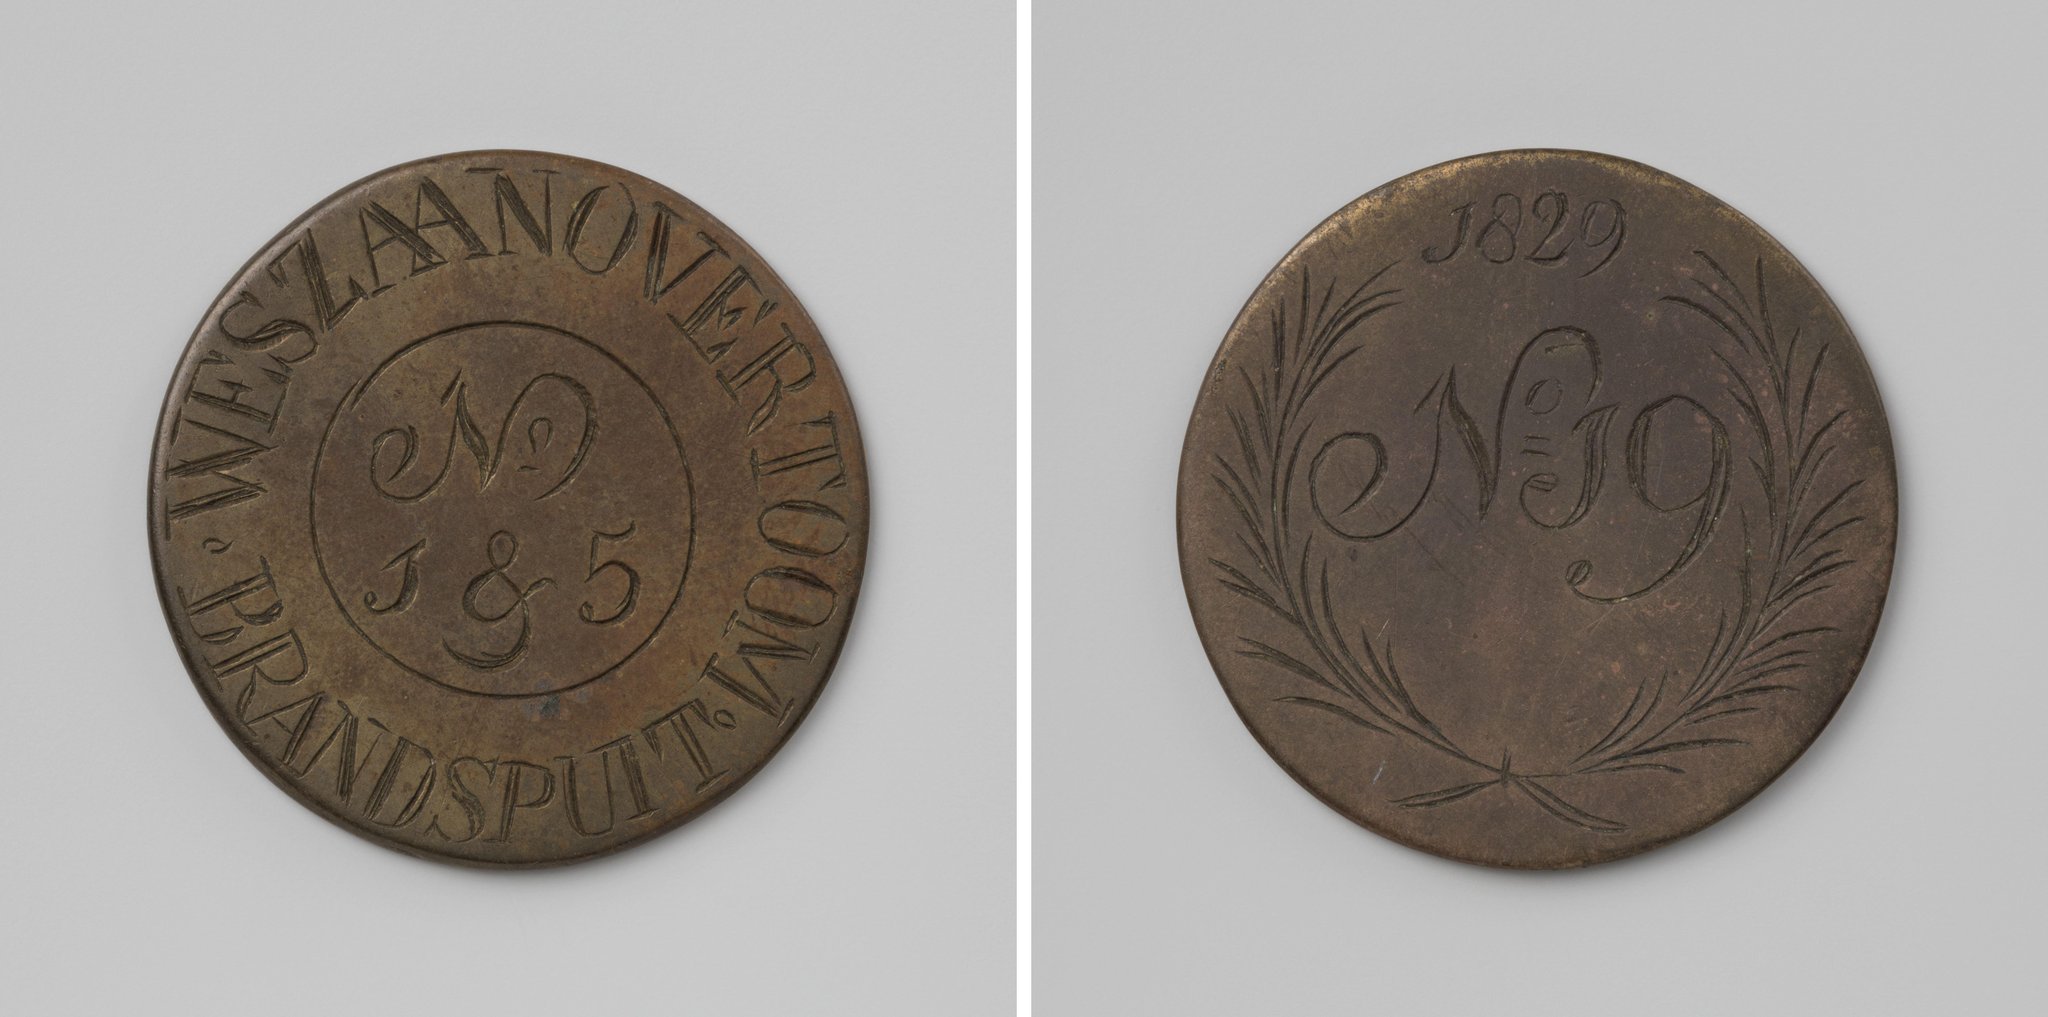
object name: fire engine medal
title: West Zaan Overtoom, brandspuitpenning met no. 19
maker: Anonymous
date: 1829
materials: brass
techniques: engraving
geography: westzaan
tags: overtoom, westzaan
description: Messing penning. Voorzijde: opschrift No. 1 & 5 binnen cirkel en omschrift. Keerzijde: opschrift No. 19 binnen krans van wilgetakken onder jaartal